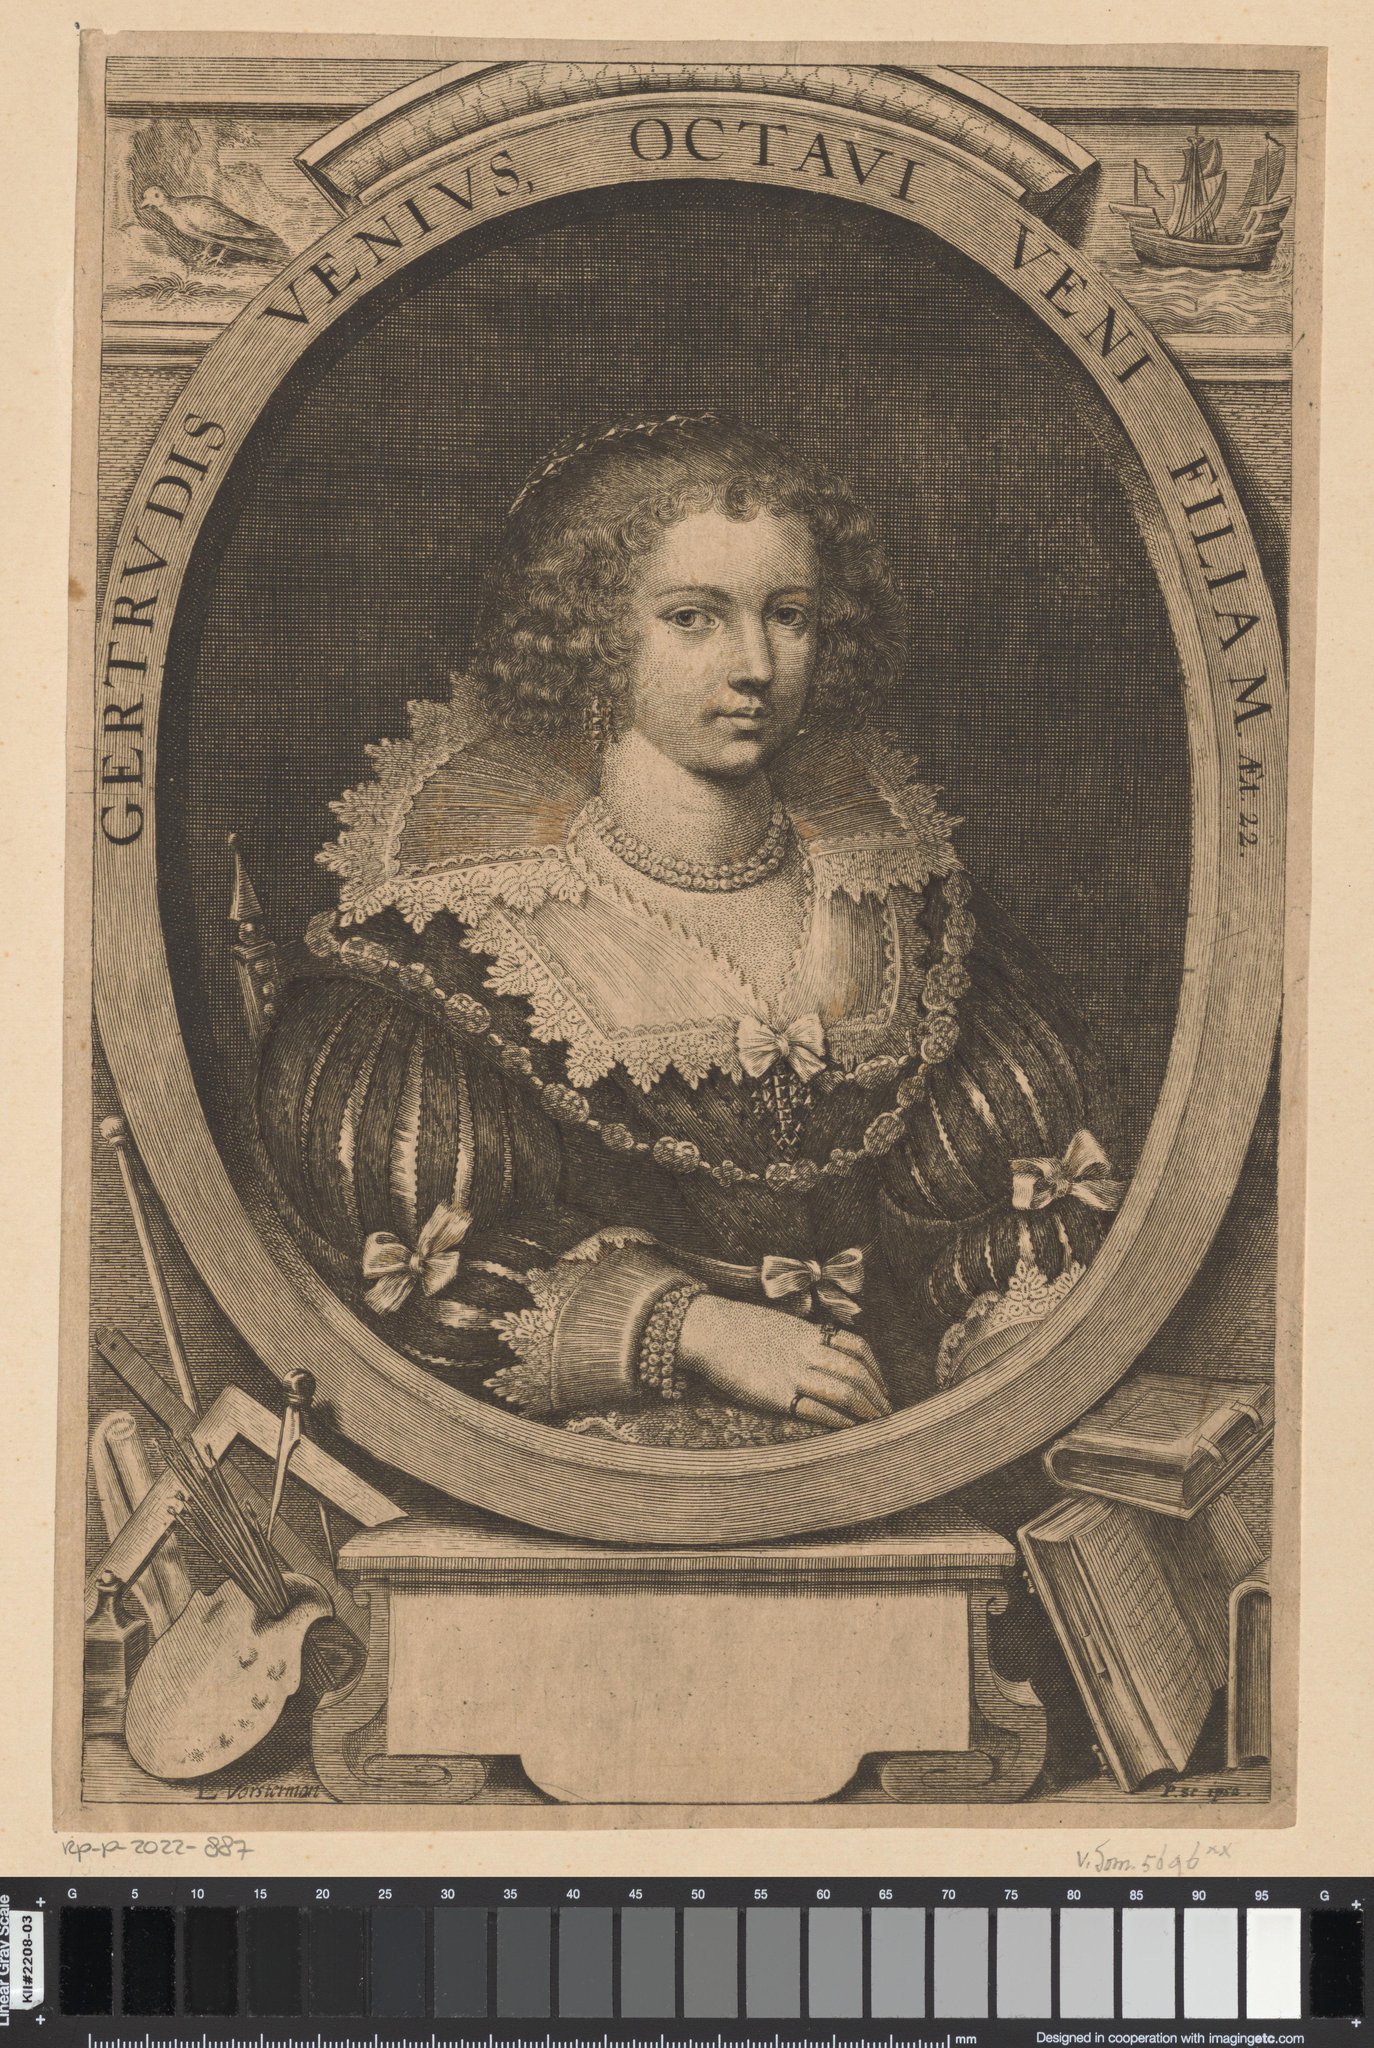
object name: print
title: Portret van Gertruida van Veen op 22-jarige leeftijd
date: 1624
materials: ink, paper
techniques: engraving, pen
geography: antwerp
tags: antwerp, painter, draughtsman, gertruida van veen, drawing-instruments, historical persons - bb - woman, ships (in general), portrait, self-portrait of painter, tools, implements of painter, book, shore-birds and wading-birds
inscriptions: collector's mark: Lugt 2228